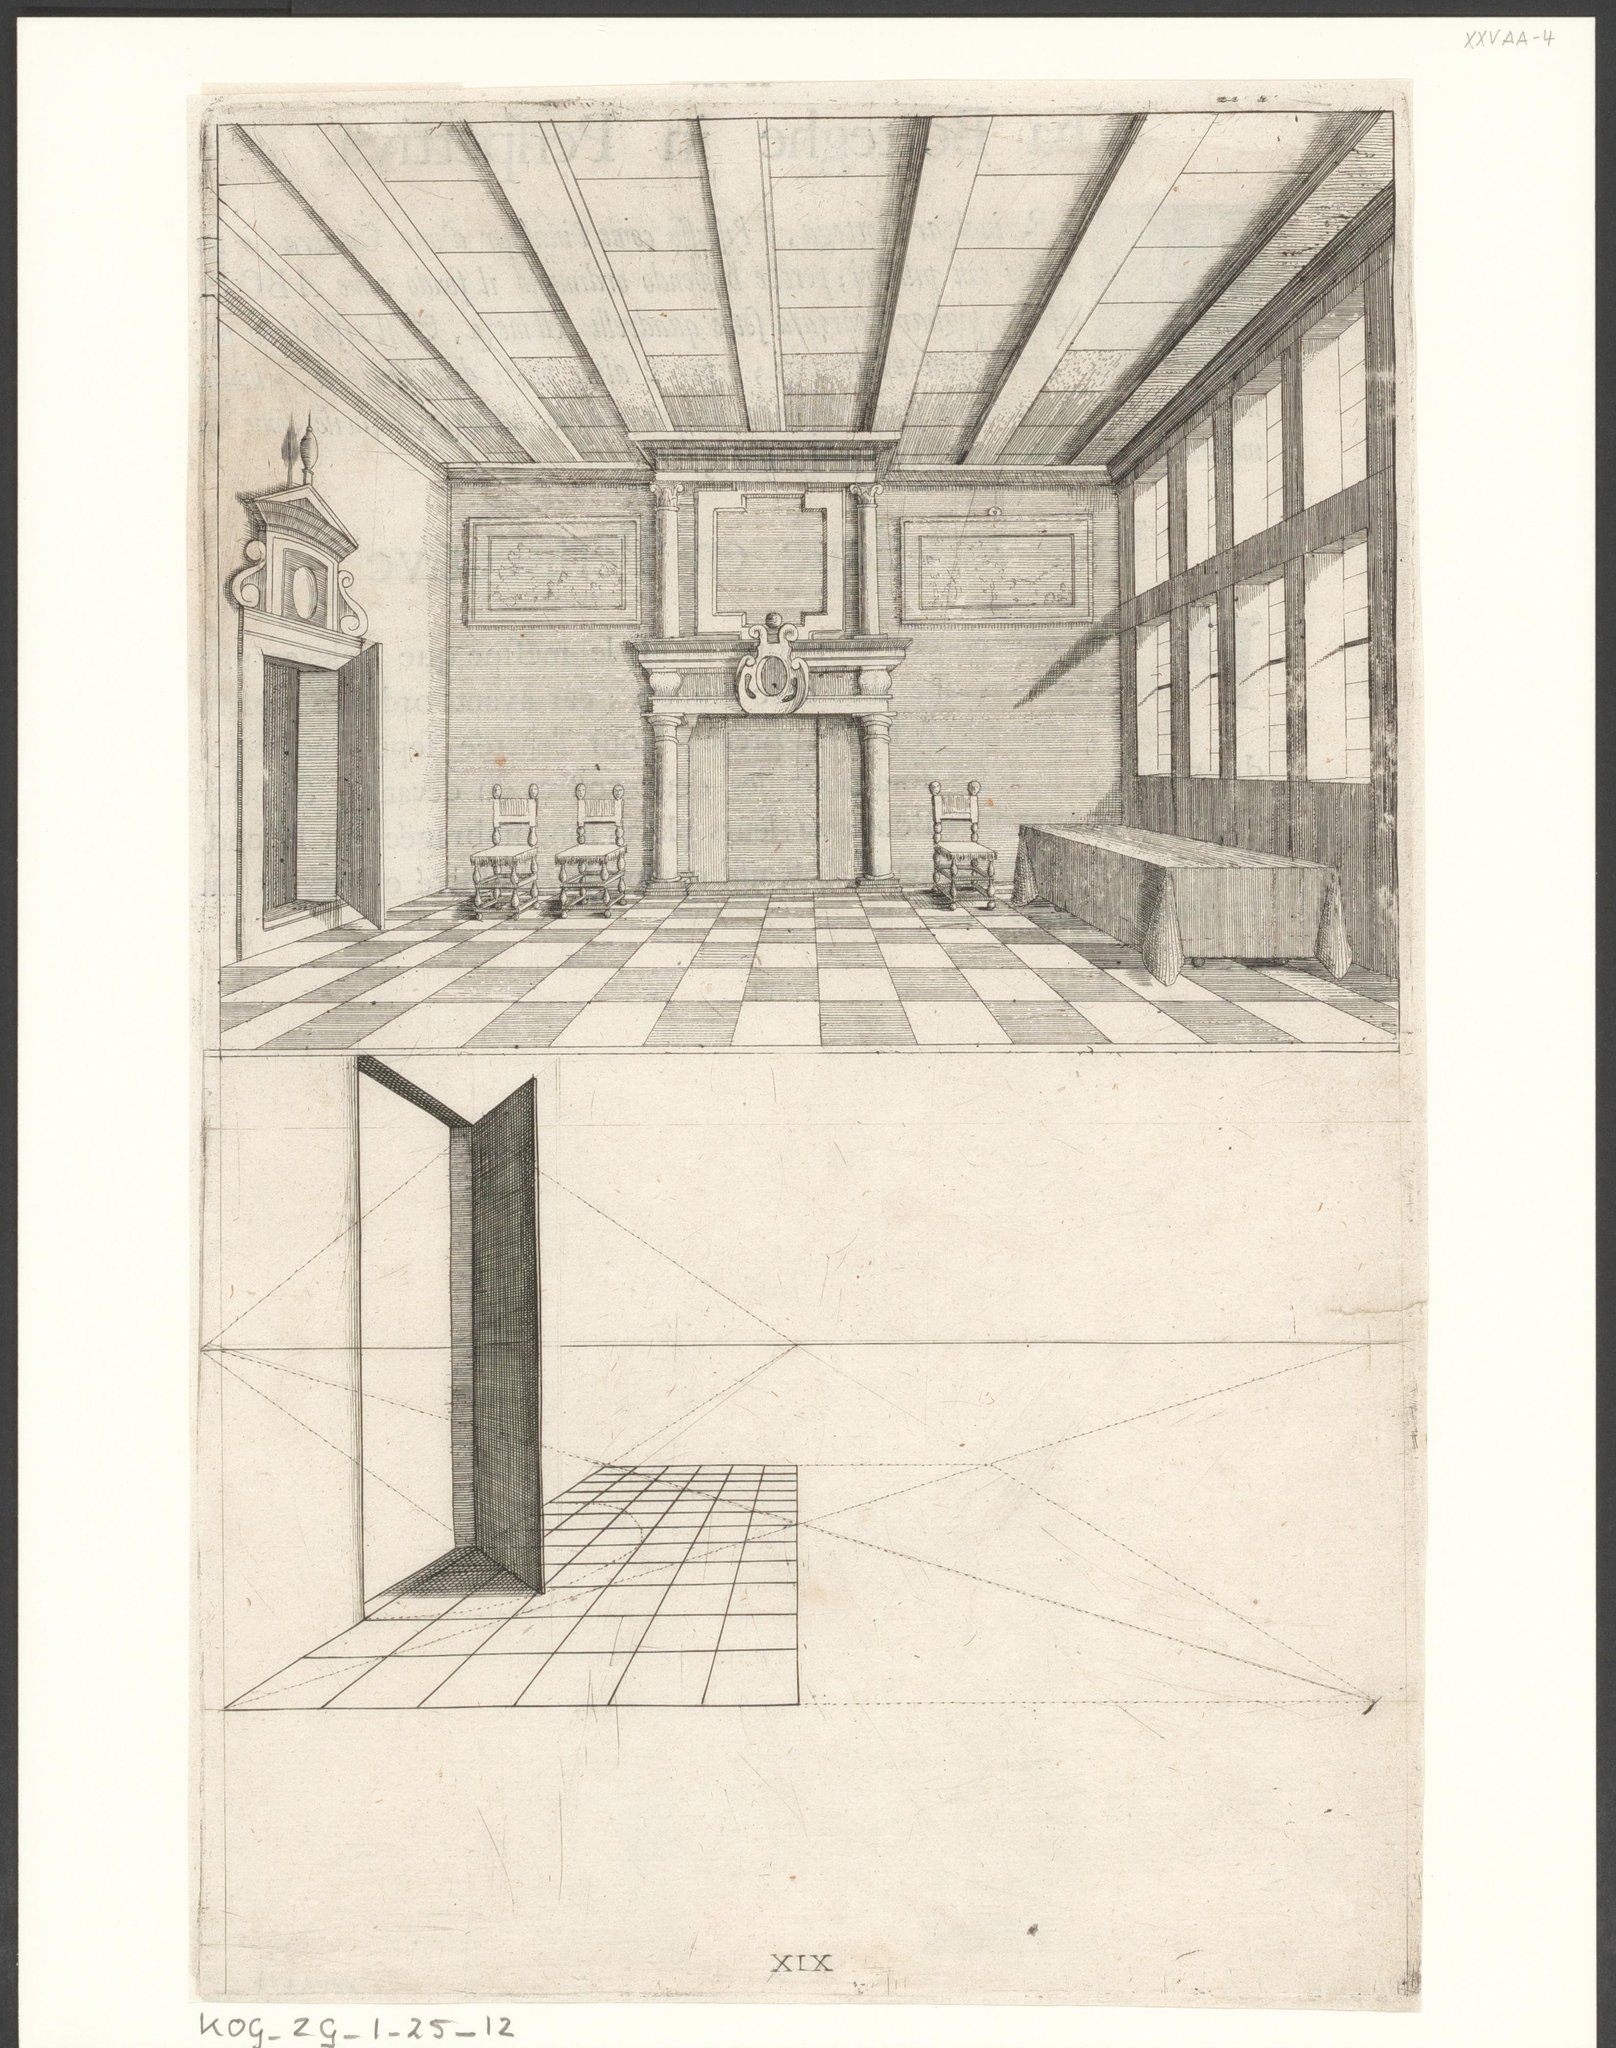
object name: print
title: Interieur van een kamer met onderaan de deur in perspectief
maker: Anonymous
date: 1700-1799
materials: paper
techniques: engraving, etching, letterpress printing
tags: drawing-room, 'salon', mathematical perspective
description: Interieur van een kamer met onderaan de open deur in perspectief. Onderaan genummerd: XIX. Onderwerpsrubrieken binnen de Atlas Zeden en Gewoonten: Zeden en Gewoonten in Engeren Zin, De Woning, Binnenhuizen, Kamerbetimmering.